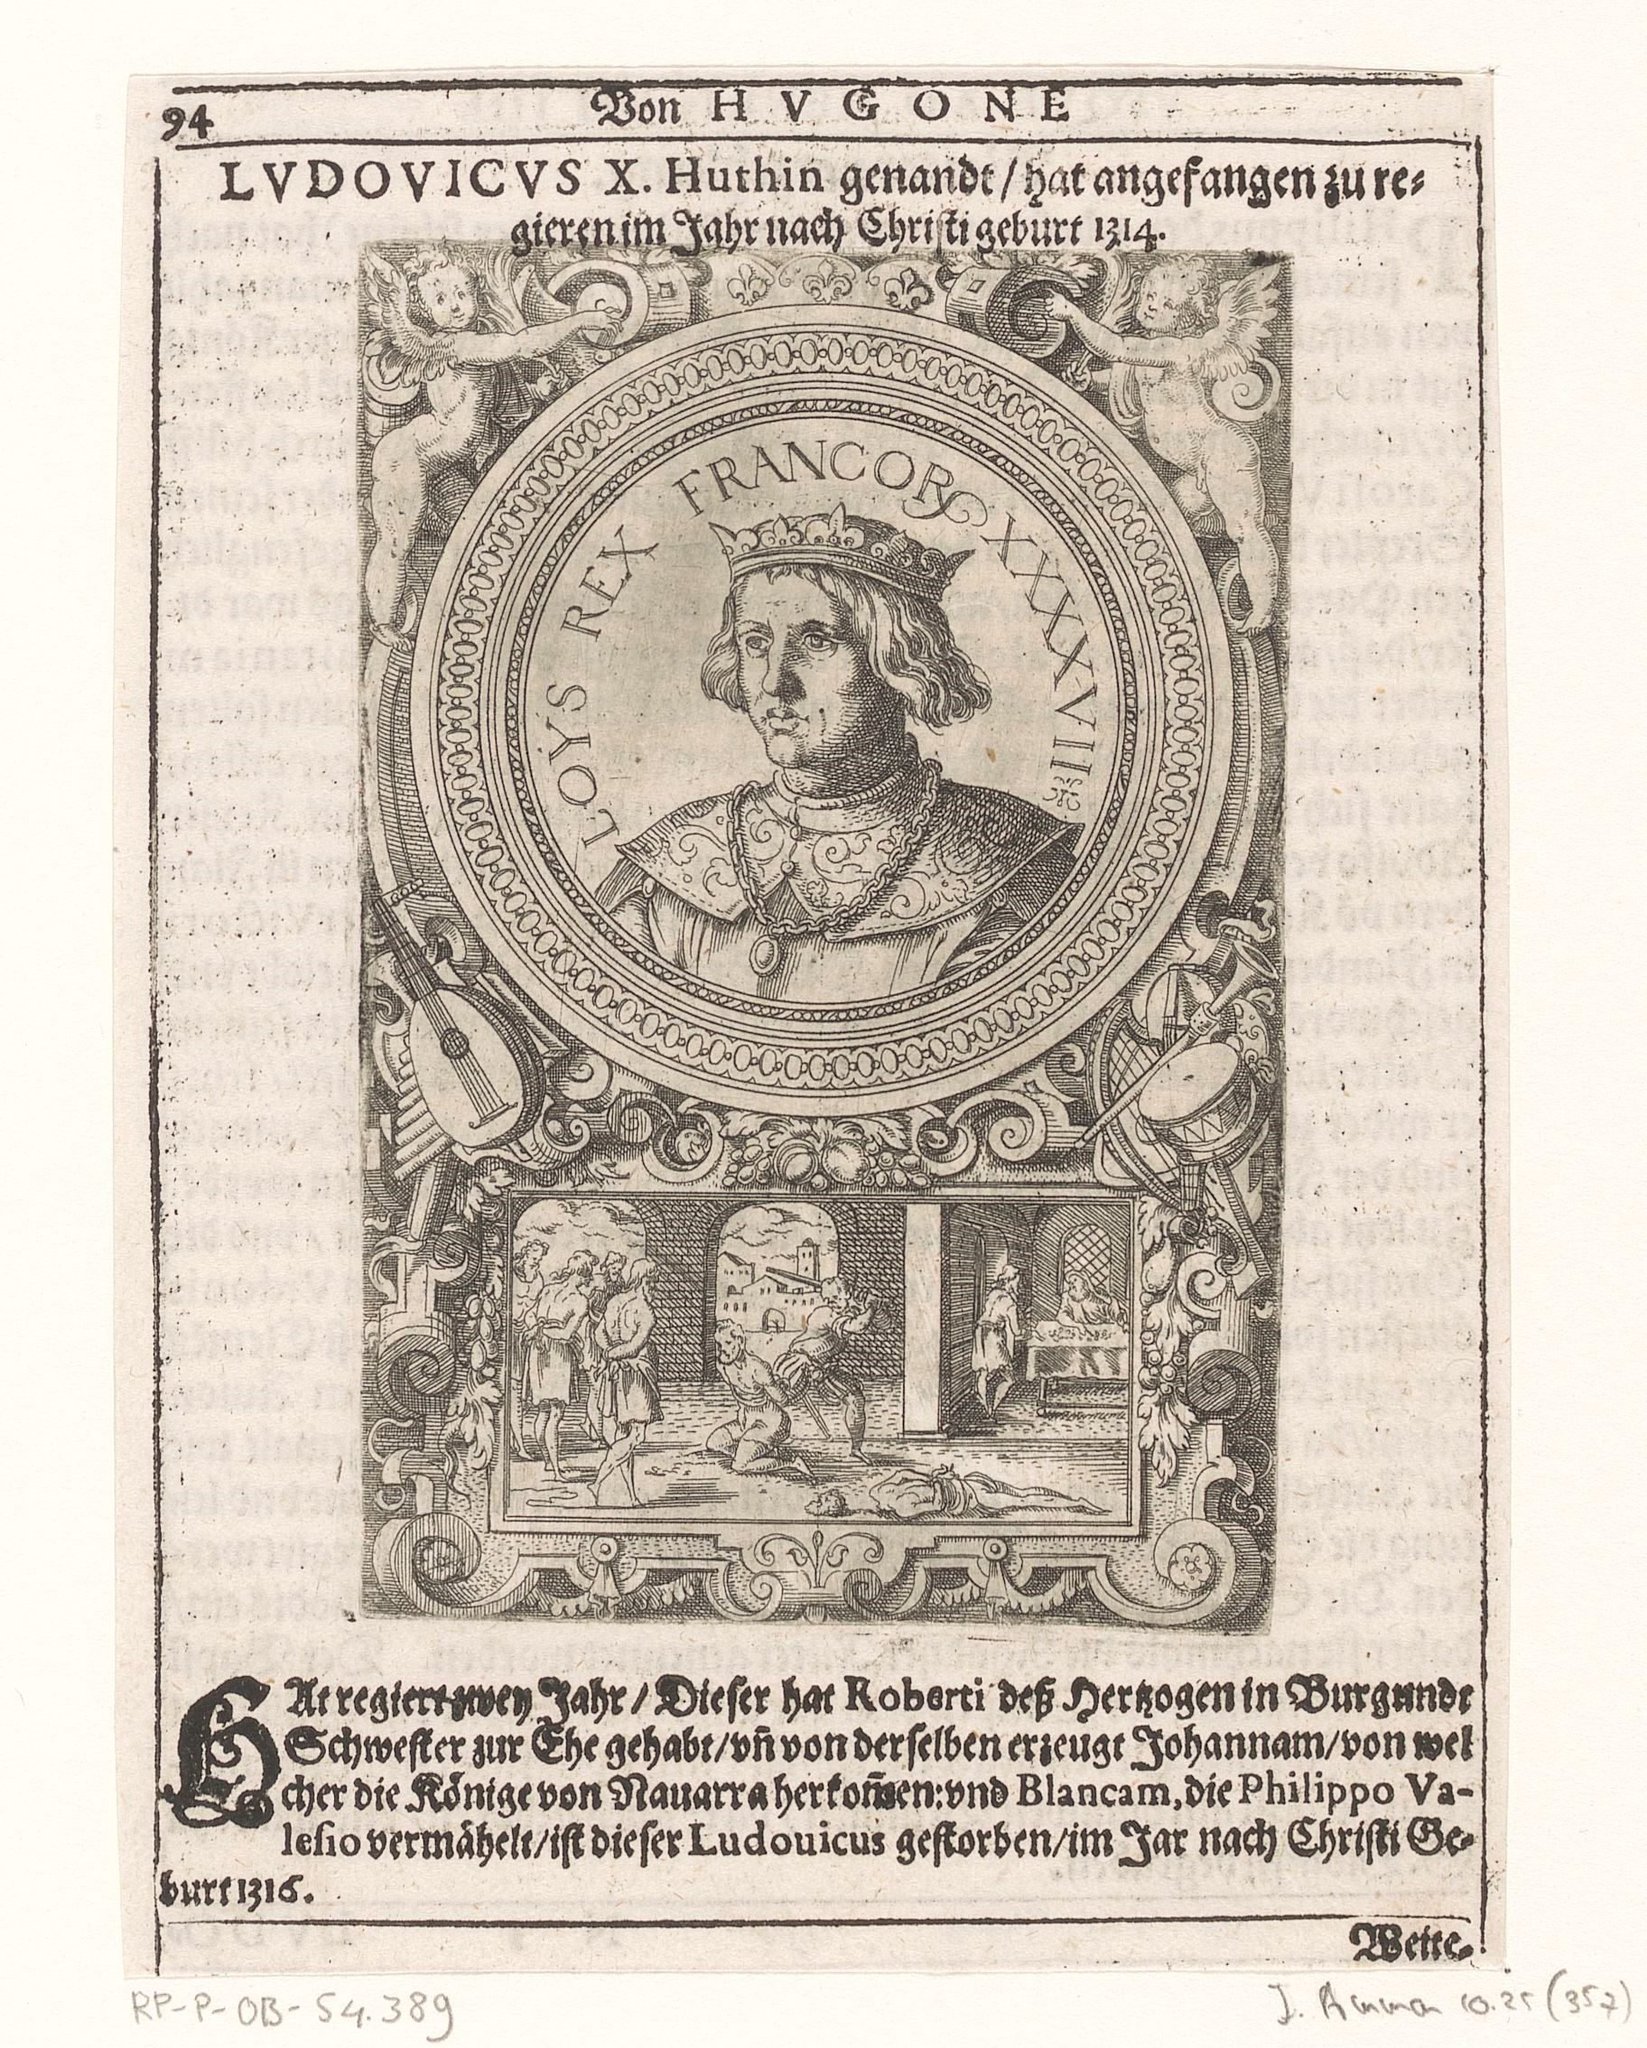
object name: book illustration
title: Portret van Lodewijk X, koning van Frankrijk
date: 1598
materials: paper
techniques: etching, intaglio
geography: nuremberg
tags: paris, scrollwork, strapwork ~ ornament, historical persons, ruler, sovereign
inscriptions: number: ‘158’, collector's mark: Lugt 2228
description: Prent afkomstig uit de publicatie: Michael Eizinger. Könige in Frankreich. Keulen: Johann Bussemacher, 1598, p. 94. De publicatie bevat prenten van Jost Amman en Virgil Solis.